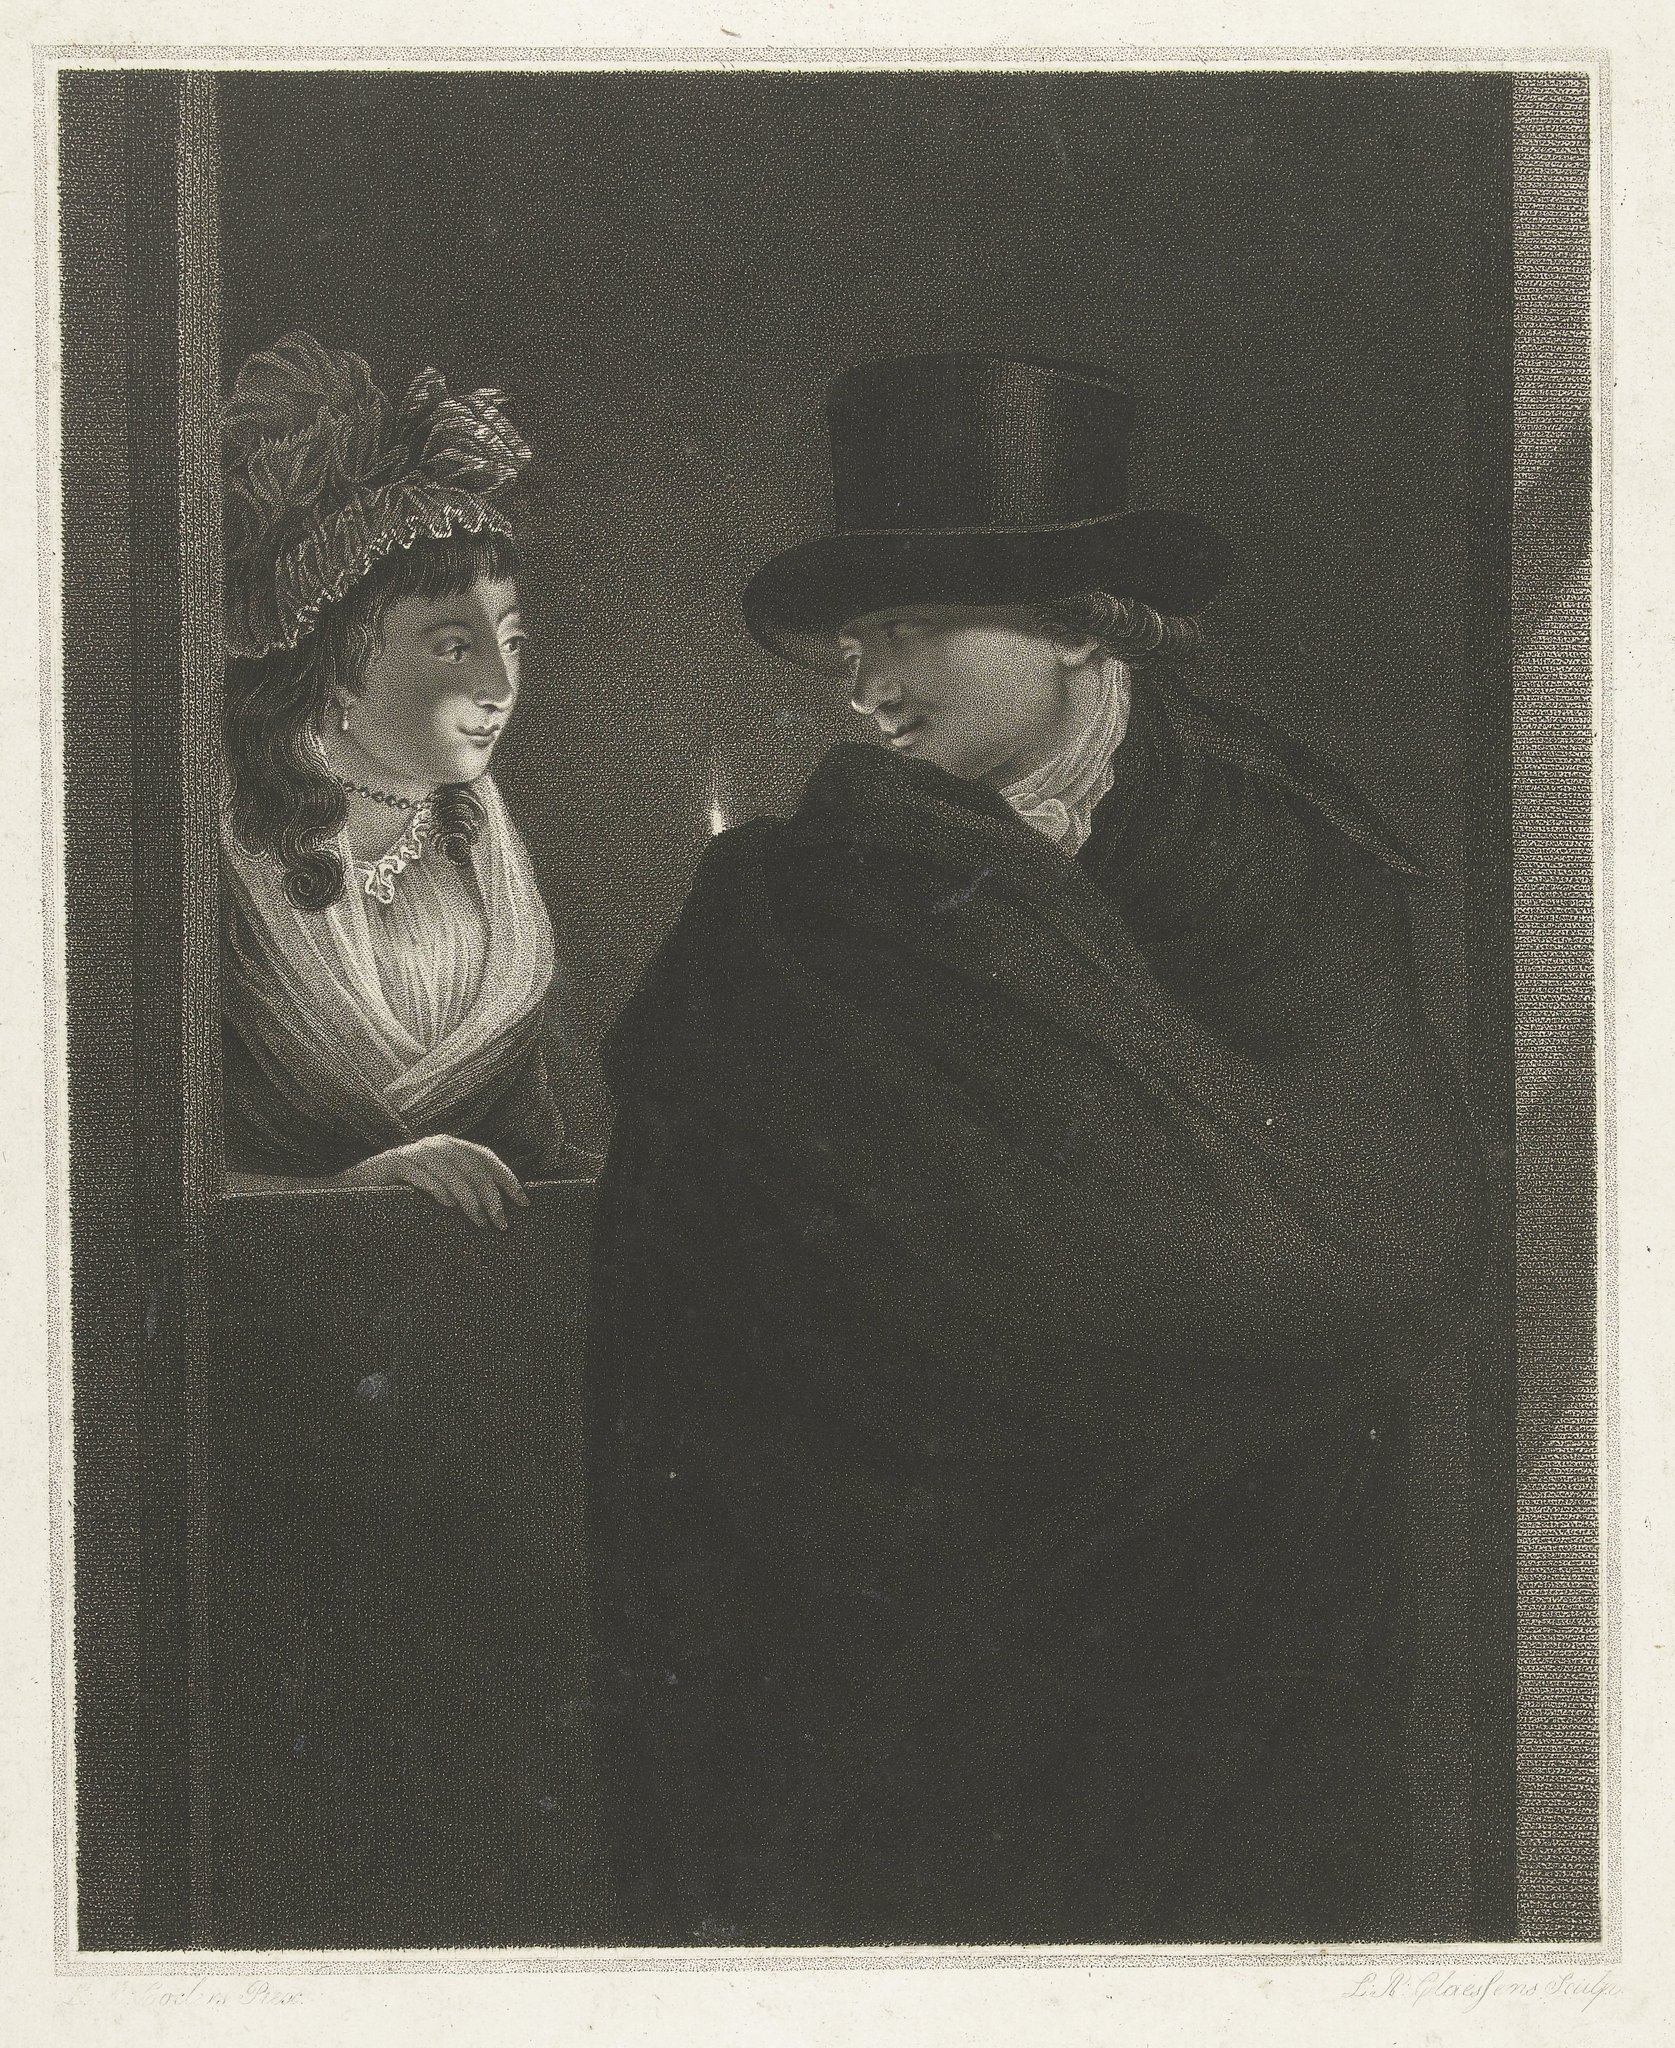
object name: print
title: Amante inconstante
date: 1792-1817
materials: paper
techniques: etching, engraving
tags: parting, leave-taking (of lovers)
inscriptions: collector's mark: Lugt 2228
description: Een heer met hoed en mantel neemt aan de deur afscheid van een jonge vrouw. De vrouw staat met een brandende kaars in haar hand en sluit met haar andere hand de onderdeur van het huis terwijl ze haar geliefde in de ogen kijkt. Deze prent vormt een pendant met een voorstelling van de wachtende vrouw bij de deur.